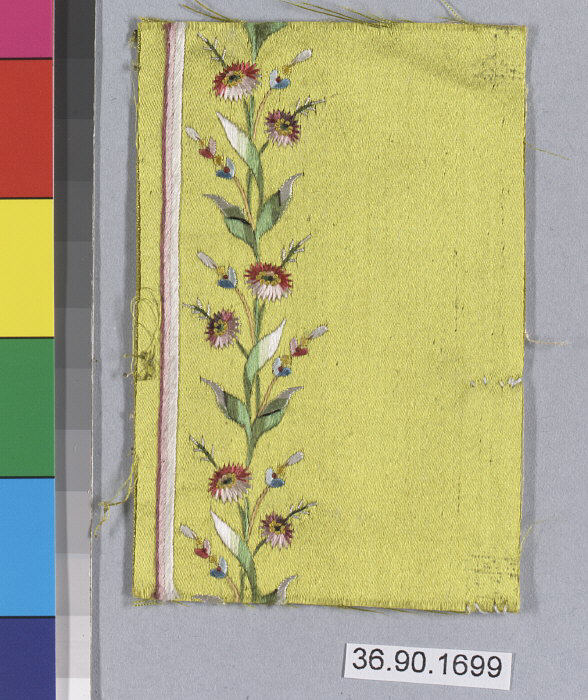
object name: sample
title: Embroidery sample for a man’s suit or waistcoat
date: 1785-1815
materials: silk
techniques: embroidery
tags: flowers